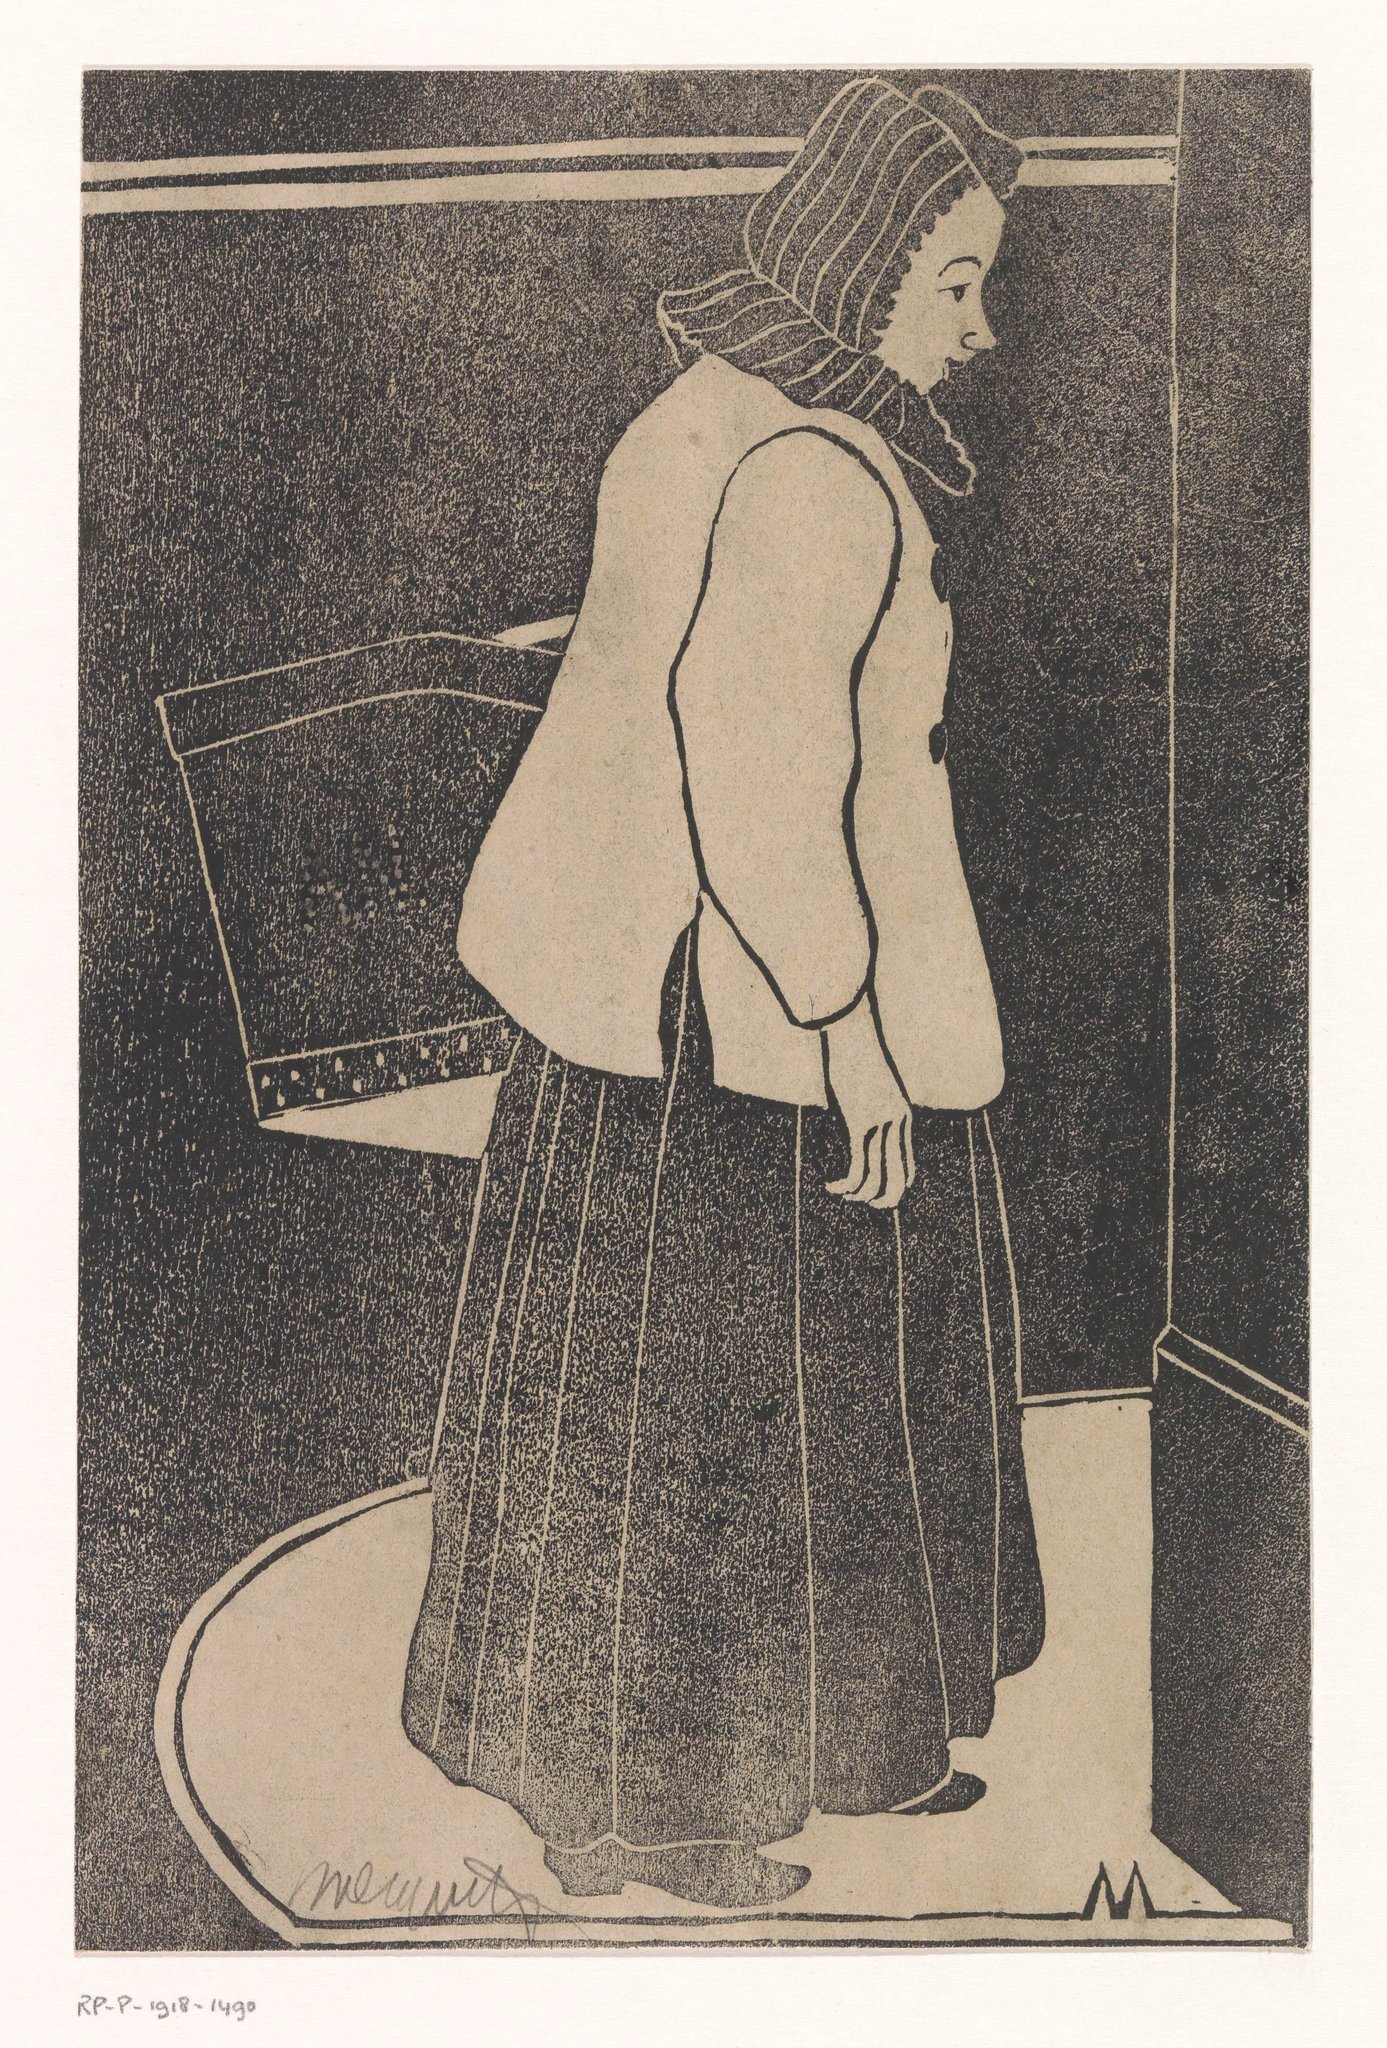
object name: print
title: Vrouw met doos of mand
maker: samuel jessurun de mesquita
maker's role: draughtsman, print maker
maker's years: 1868-1944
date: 1900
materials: paper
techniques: woodcut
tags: adult woman, carrying something in basket, bag, rucksack, etc.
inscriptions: collector's mark: Lugt 2228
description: Een vrouw staat op de hoek van een straat met onder haar arm een doos of mand met de initialen A.N.